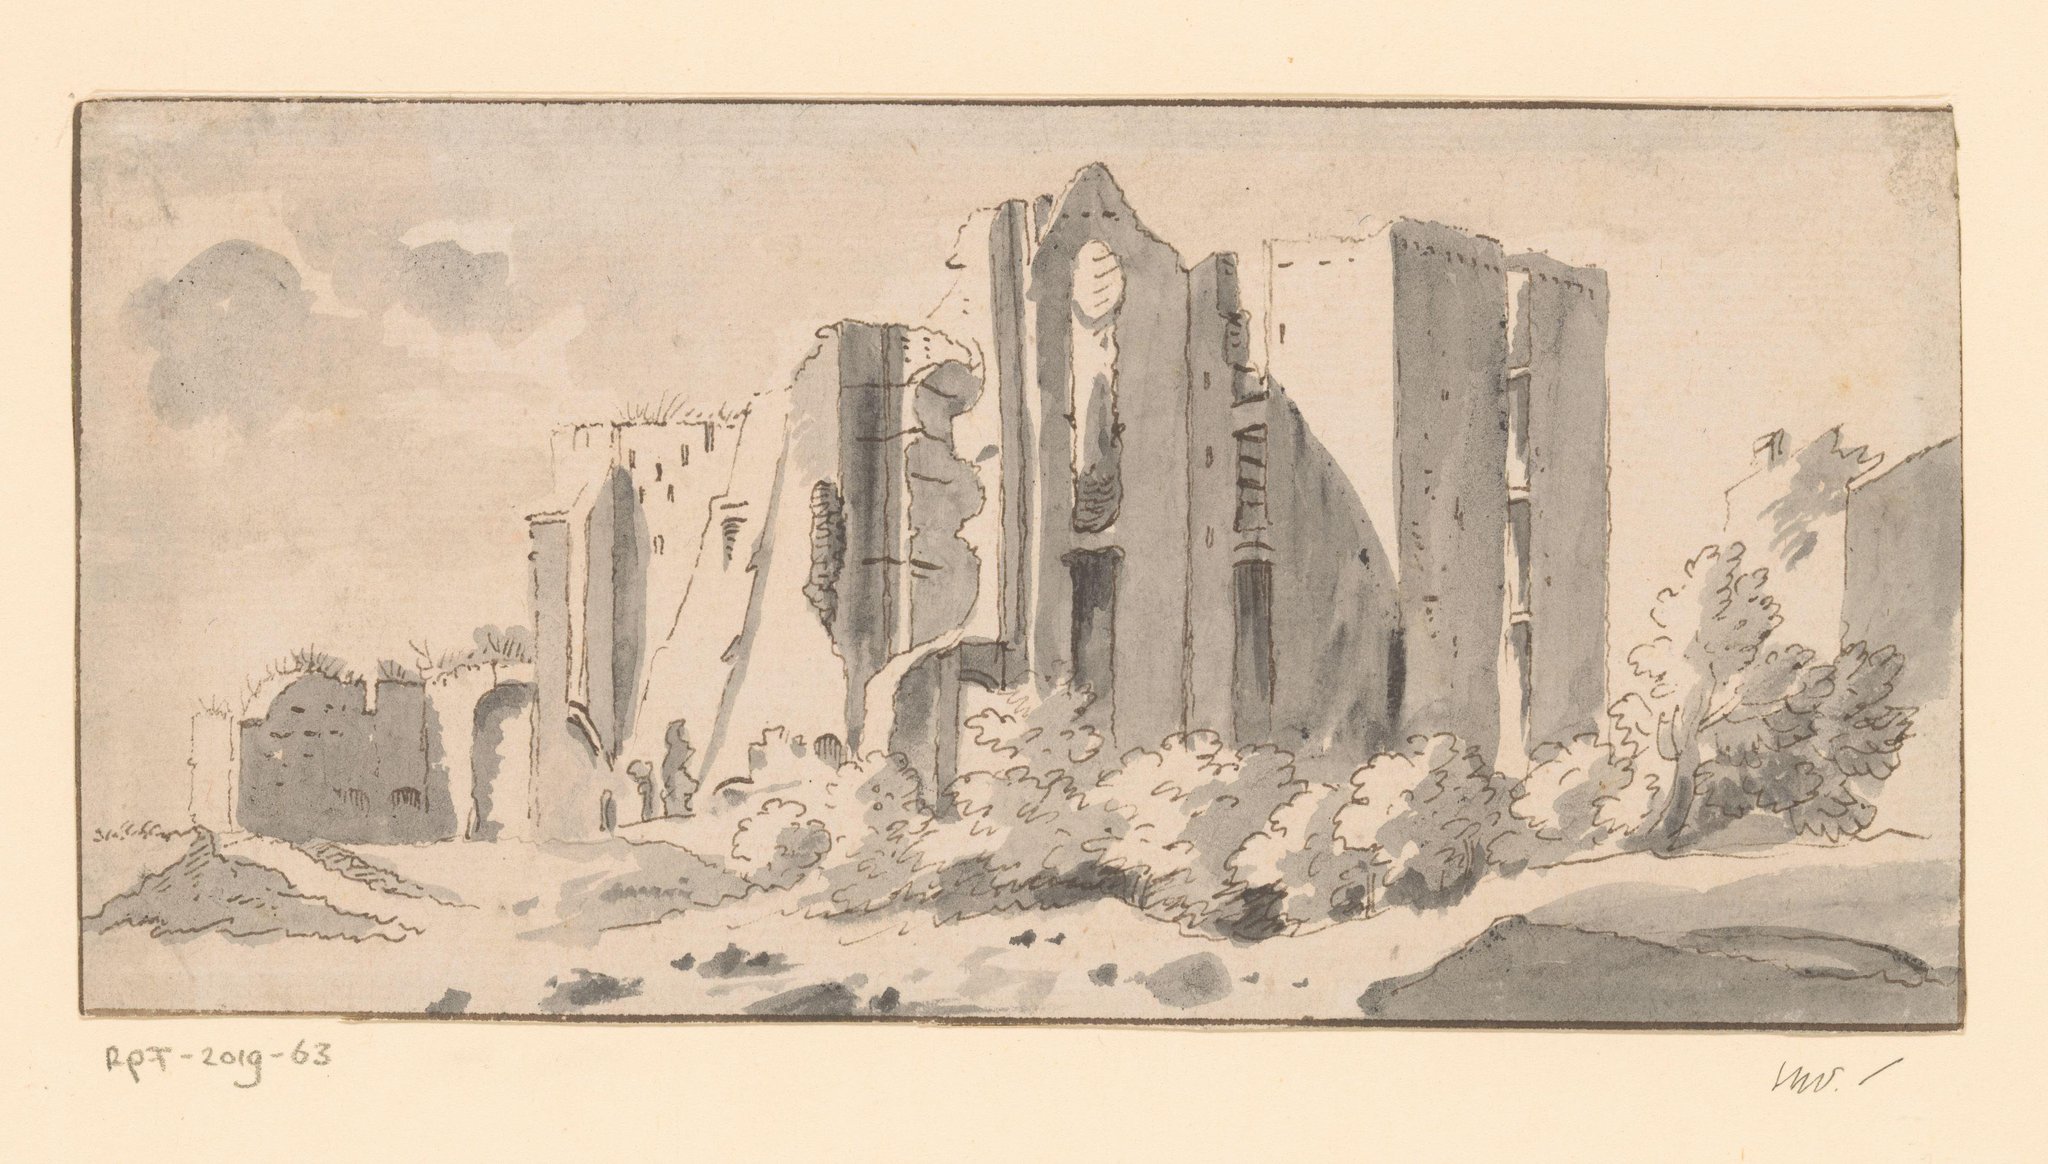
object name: drawing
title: Gezicht op de ruïnes van Kasteel Brederode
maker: Anonymous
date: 1750-1850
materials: ink, paper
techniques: brush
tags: ruin of a dwelling, house, castle, etc.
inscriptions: inscription: ‘Brederoode’